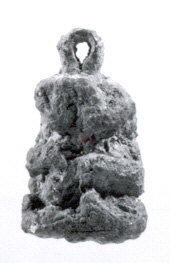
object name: stamp seal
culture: bactria-margiana archaeological complex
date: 2333-1668 BCE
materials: copper alloy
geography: bactria-margiana